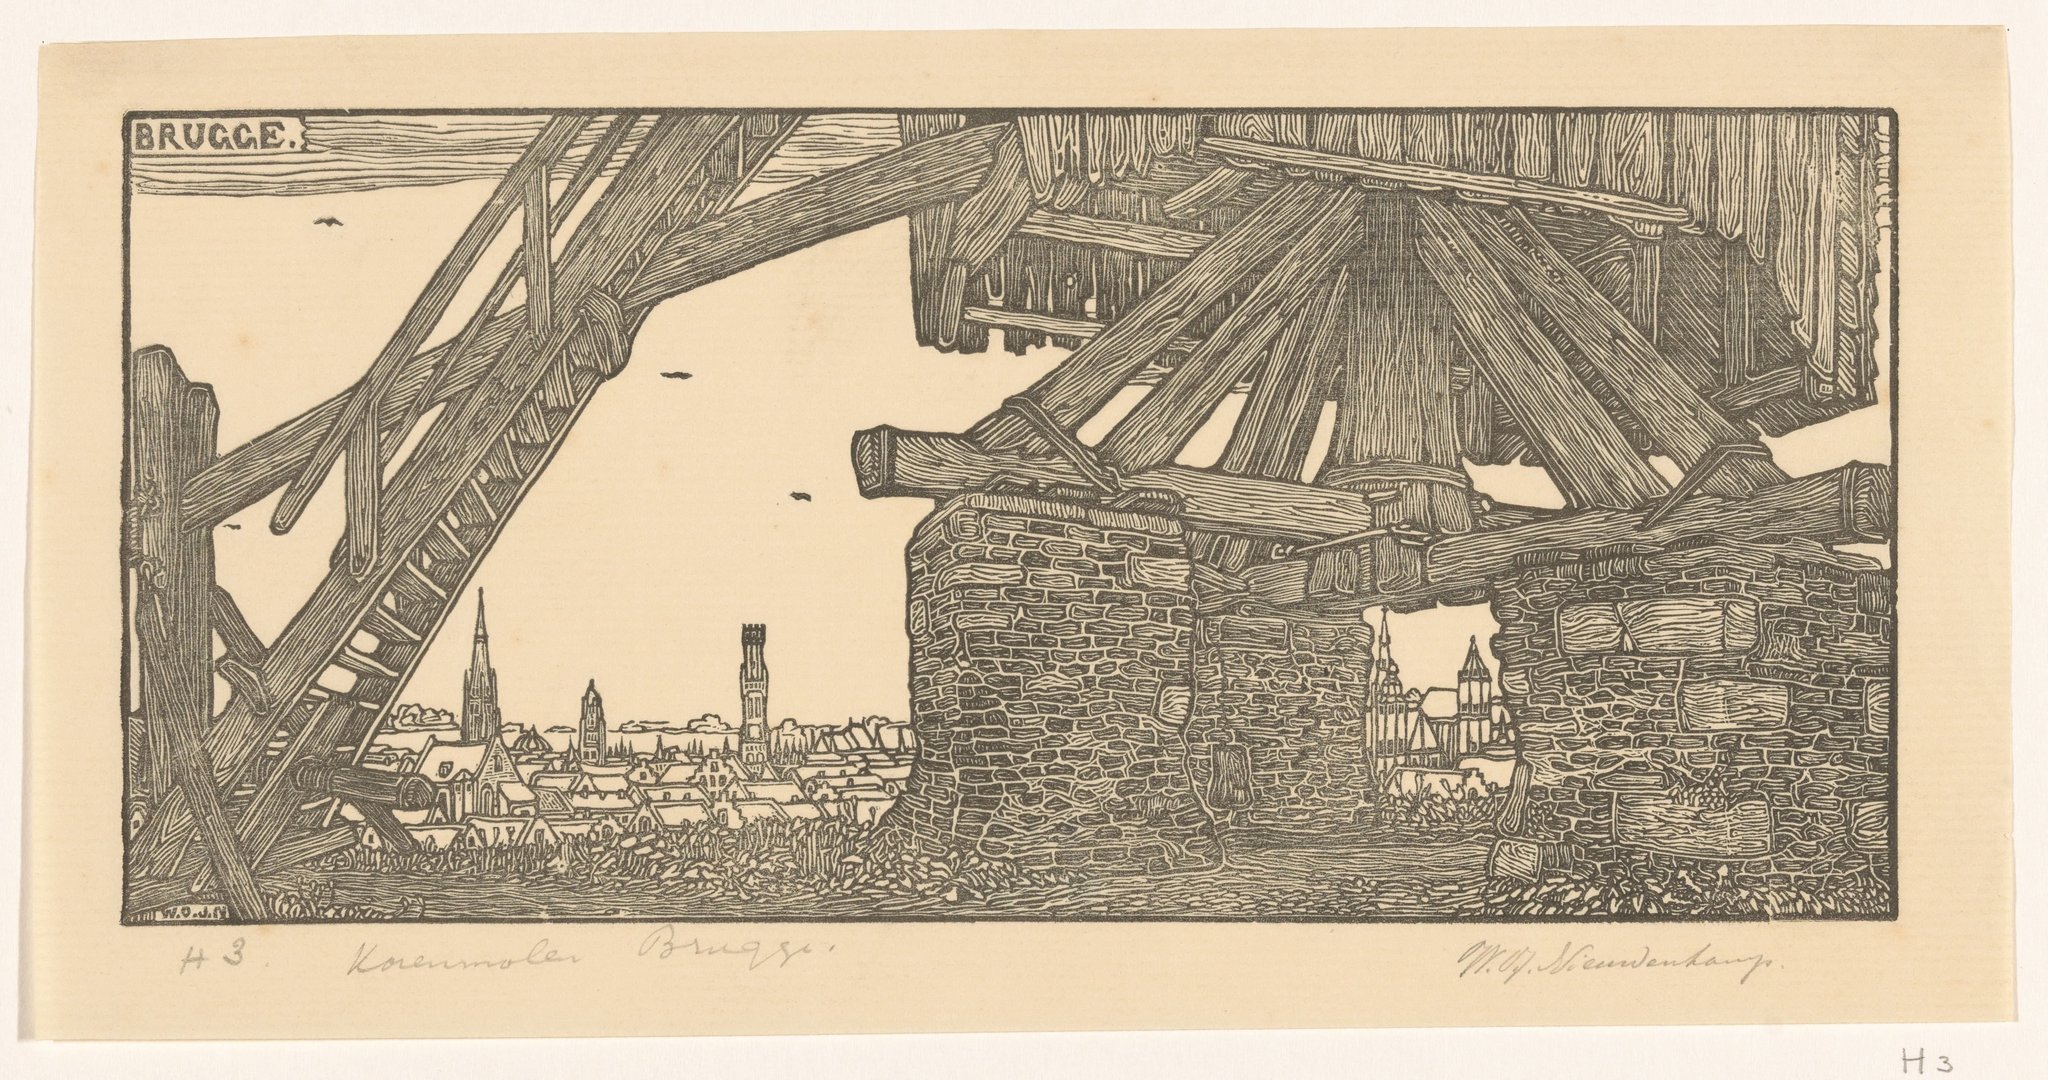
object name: print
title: Korenmolen te Brugge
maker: wijnand otto jan nieuwenkamp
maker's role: draughtsman, print maker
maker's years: 1874-1950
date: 1809-1899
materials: paper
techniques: woodcut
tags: city-view in general; 'veduta', windmill in landscape, bruges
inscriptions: collector's mark: Lugt 2233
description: Op de achtergrond het silhouet van Brugge.